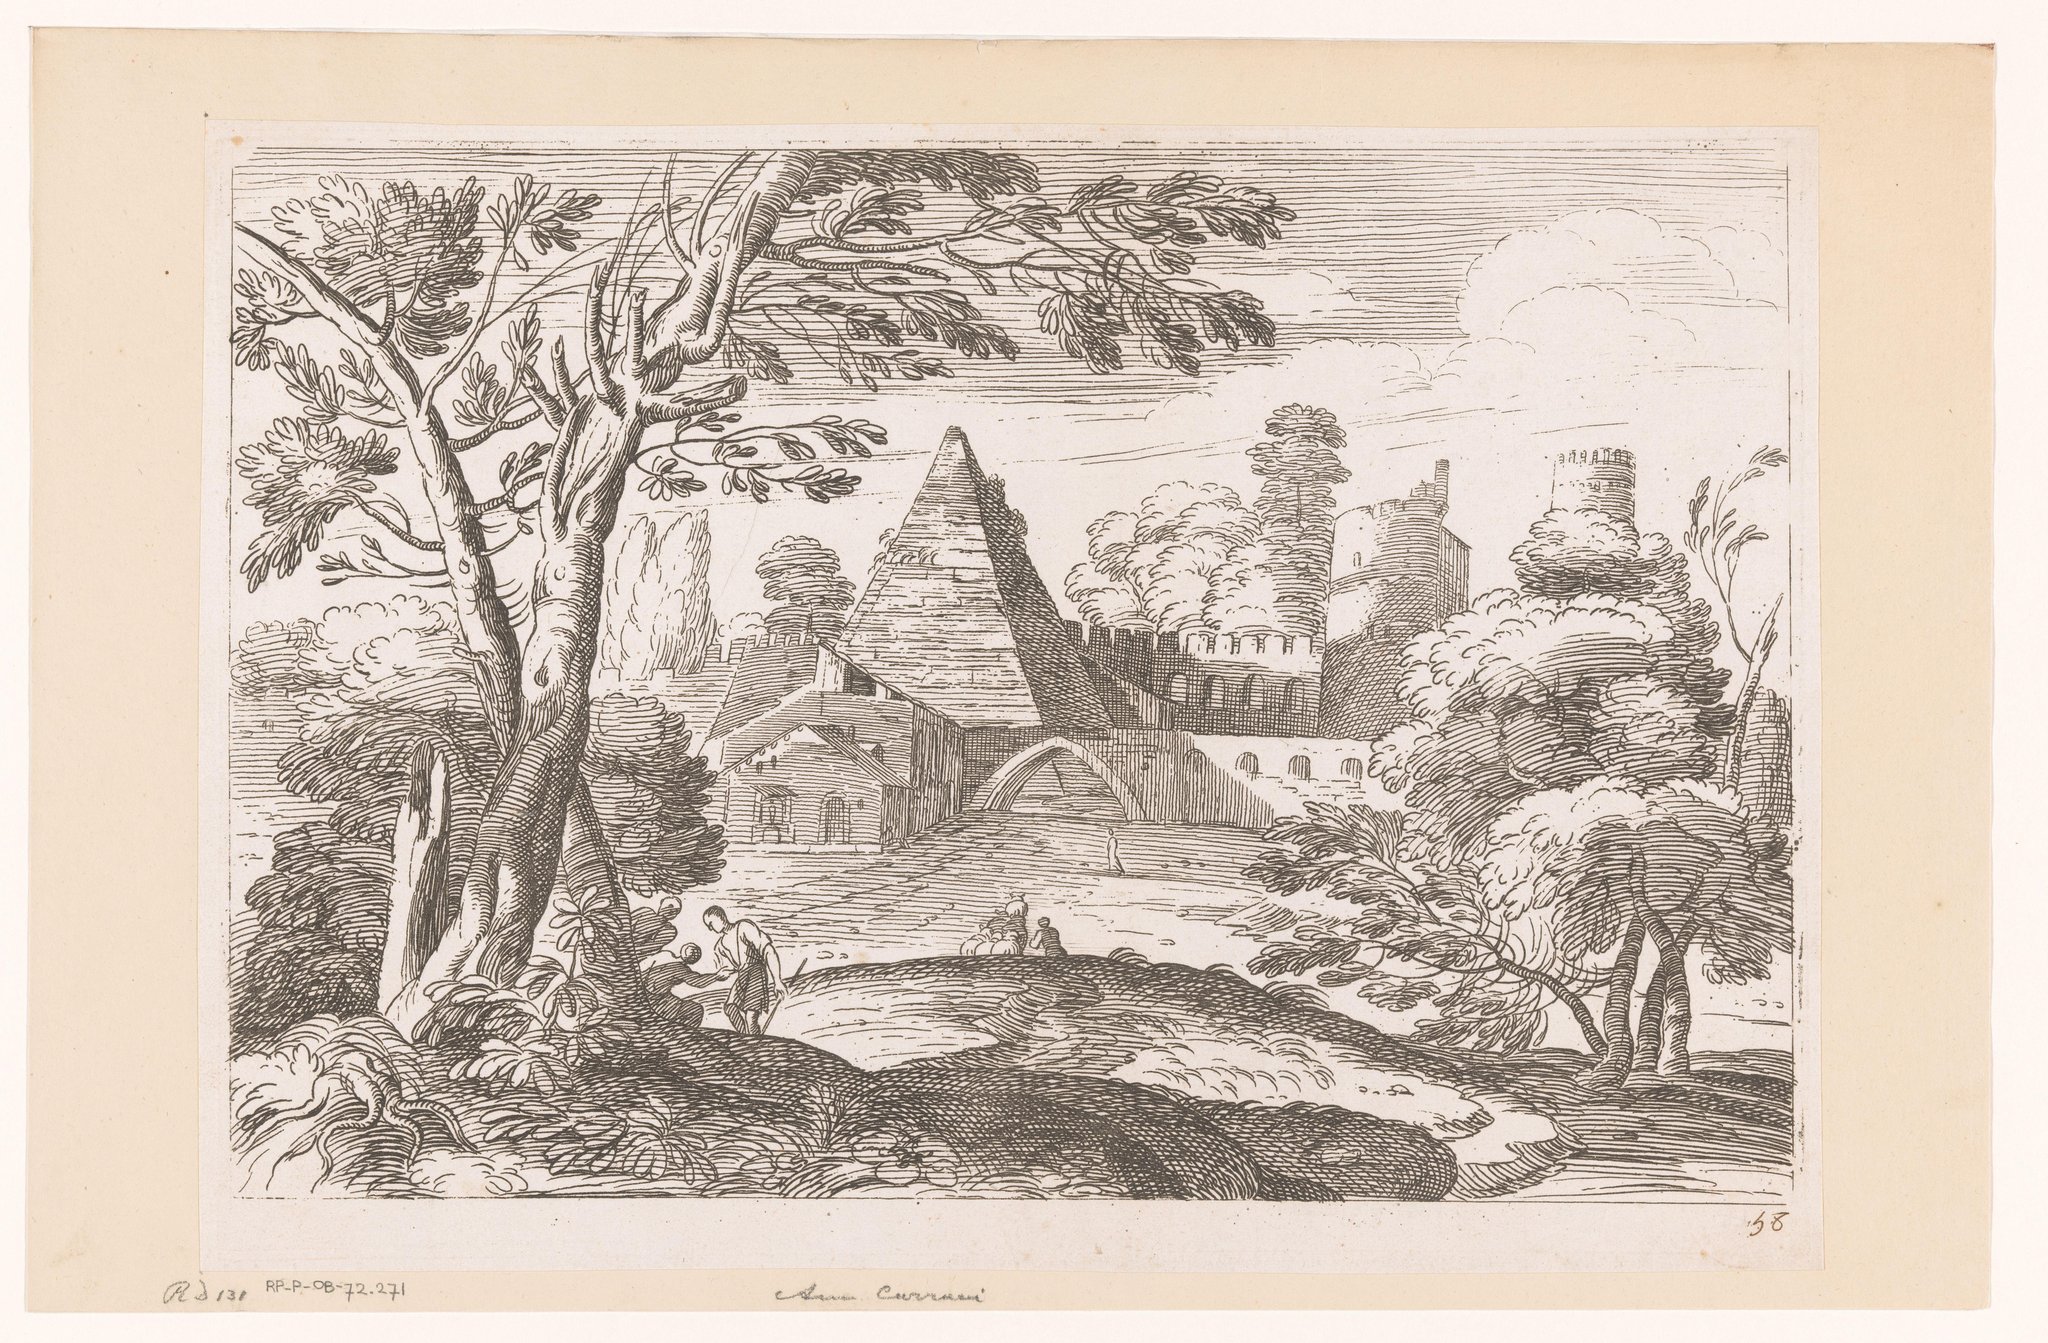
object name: print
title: Prenten naar tekeningen uit het kabinet Jabach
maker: jean pesne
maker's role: print maker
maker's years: 1623-1700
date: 1666-1695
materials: paper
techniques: etching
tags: city-view, and landscape with man-made constructions - ii - ideal landscapes, fantastic architecture, unrealistic architectural fantasies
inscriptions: collector's mark: Lugt 240, number: ‘58’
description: Prent maakt deel uit van een serie van 283 prenten, ongenummerde staat.